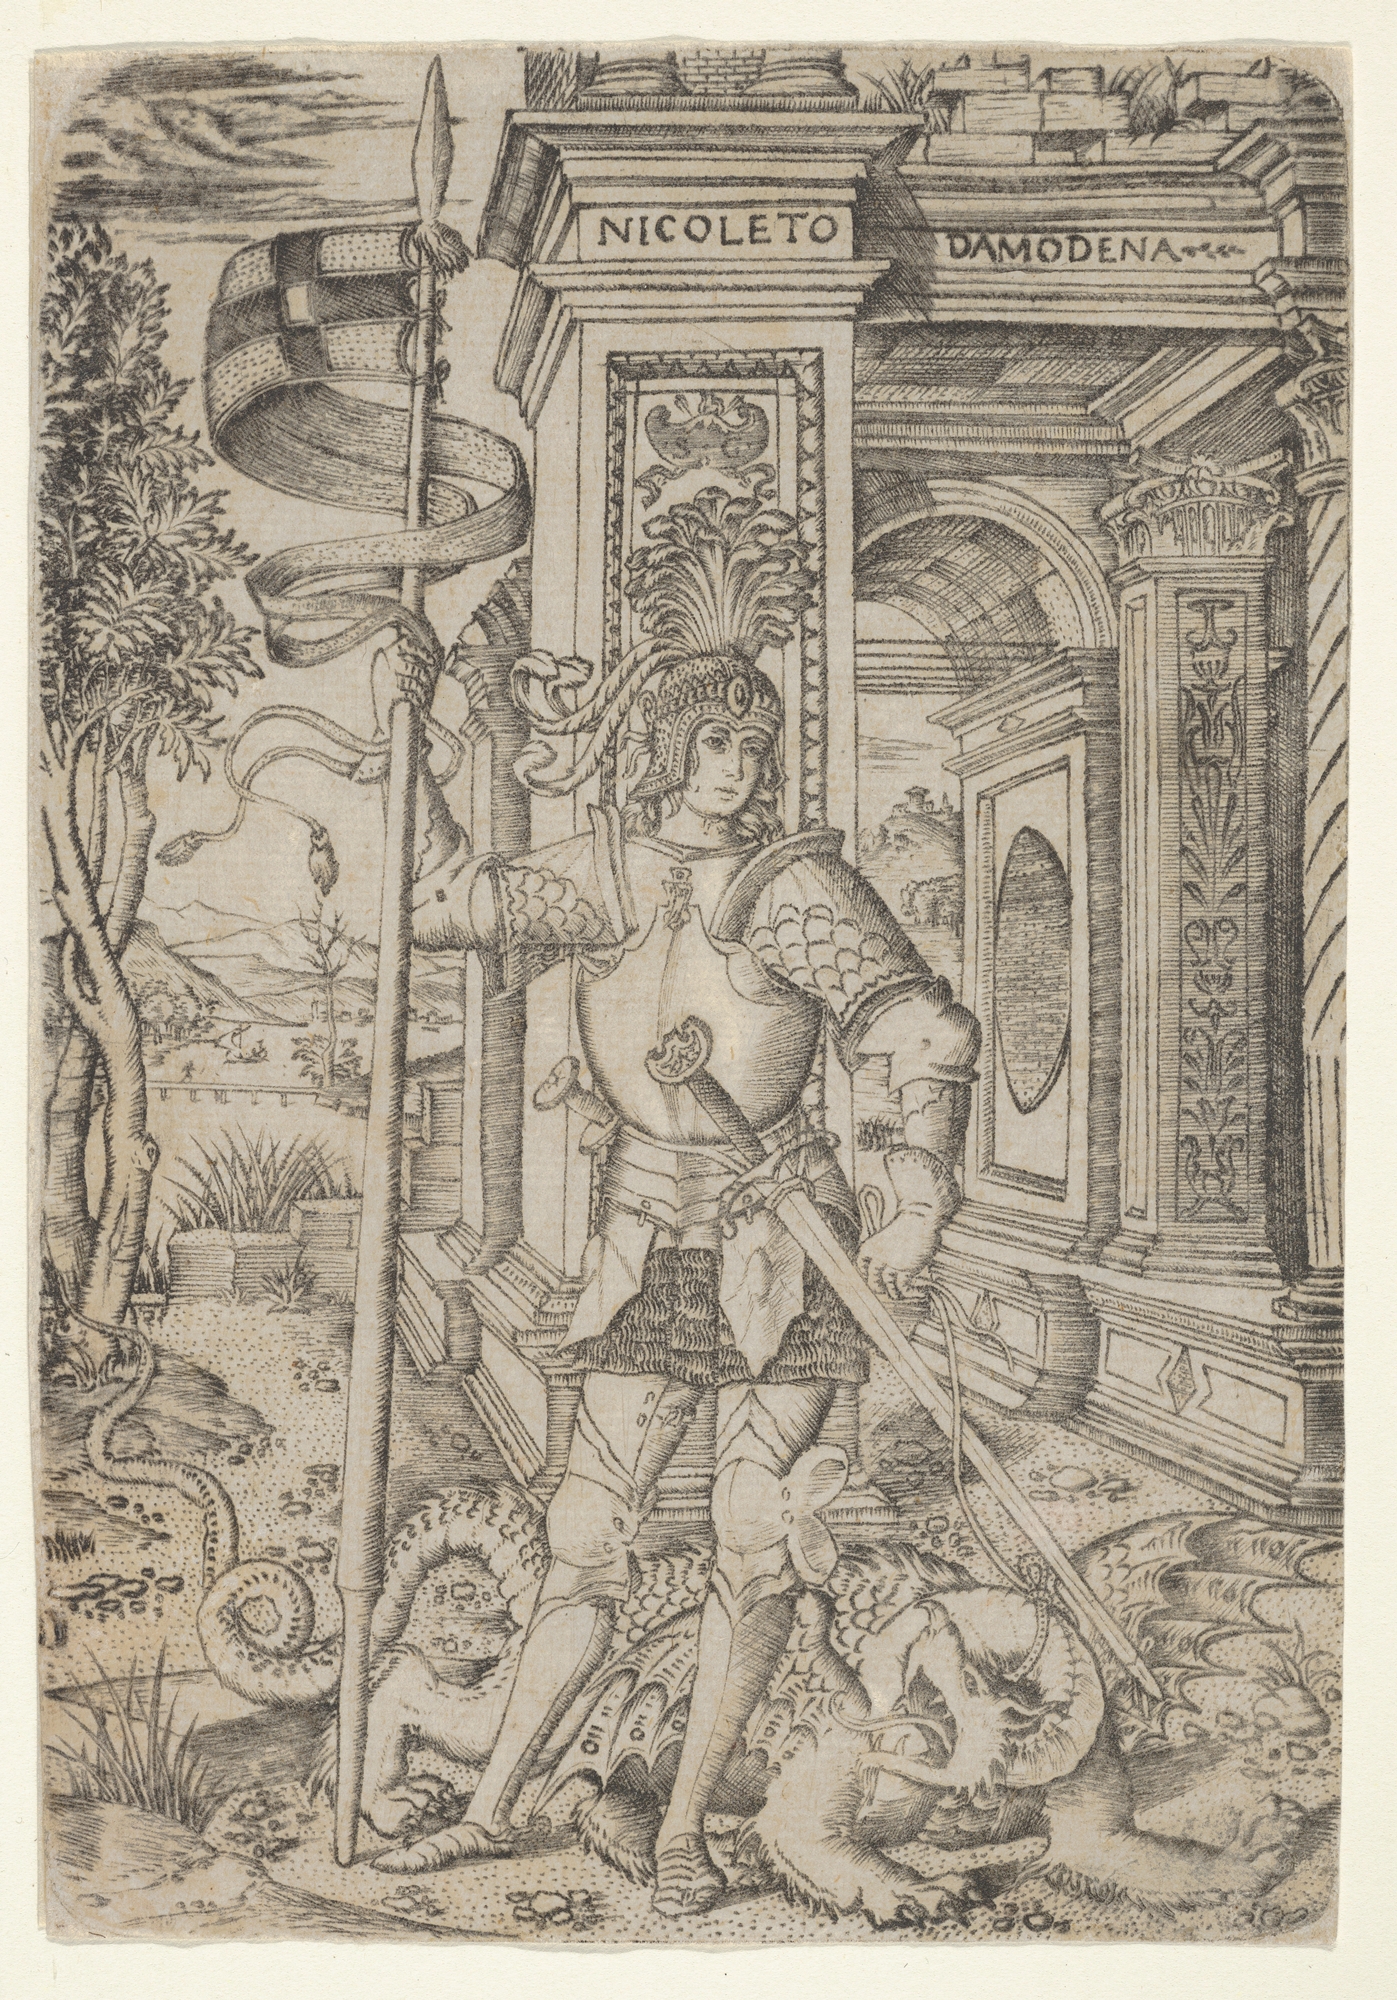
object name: print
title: St. George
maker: nicoletto da modena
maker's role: artist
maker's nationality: italian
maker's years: 1500-1520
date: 1501-1533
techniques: engraving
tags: spears,swords,dragons,saint george